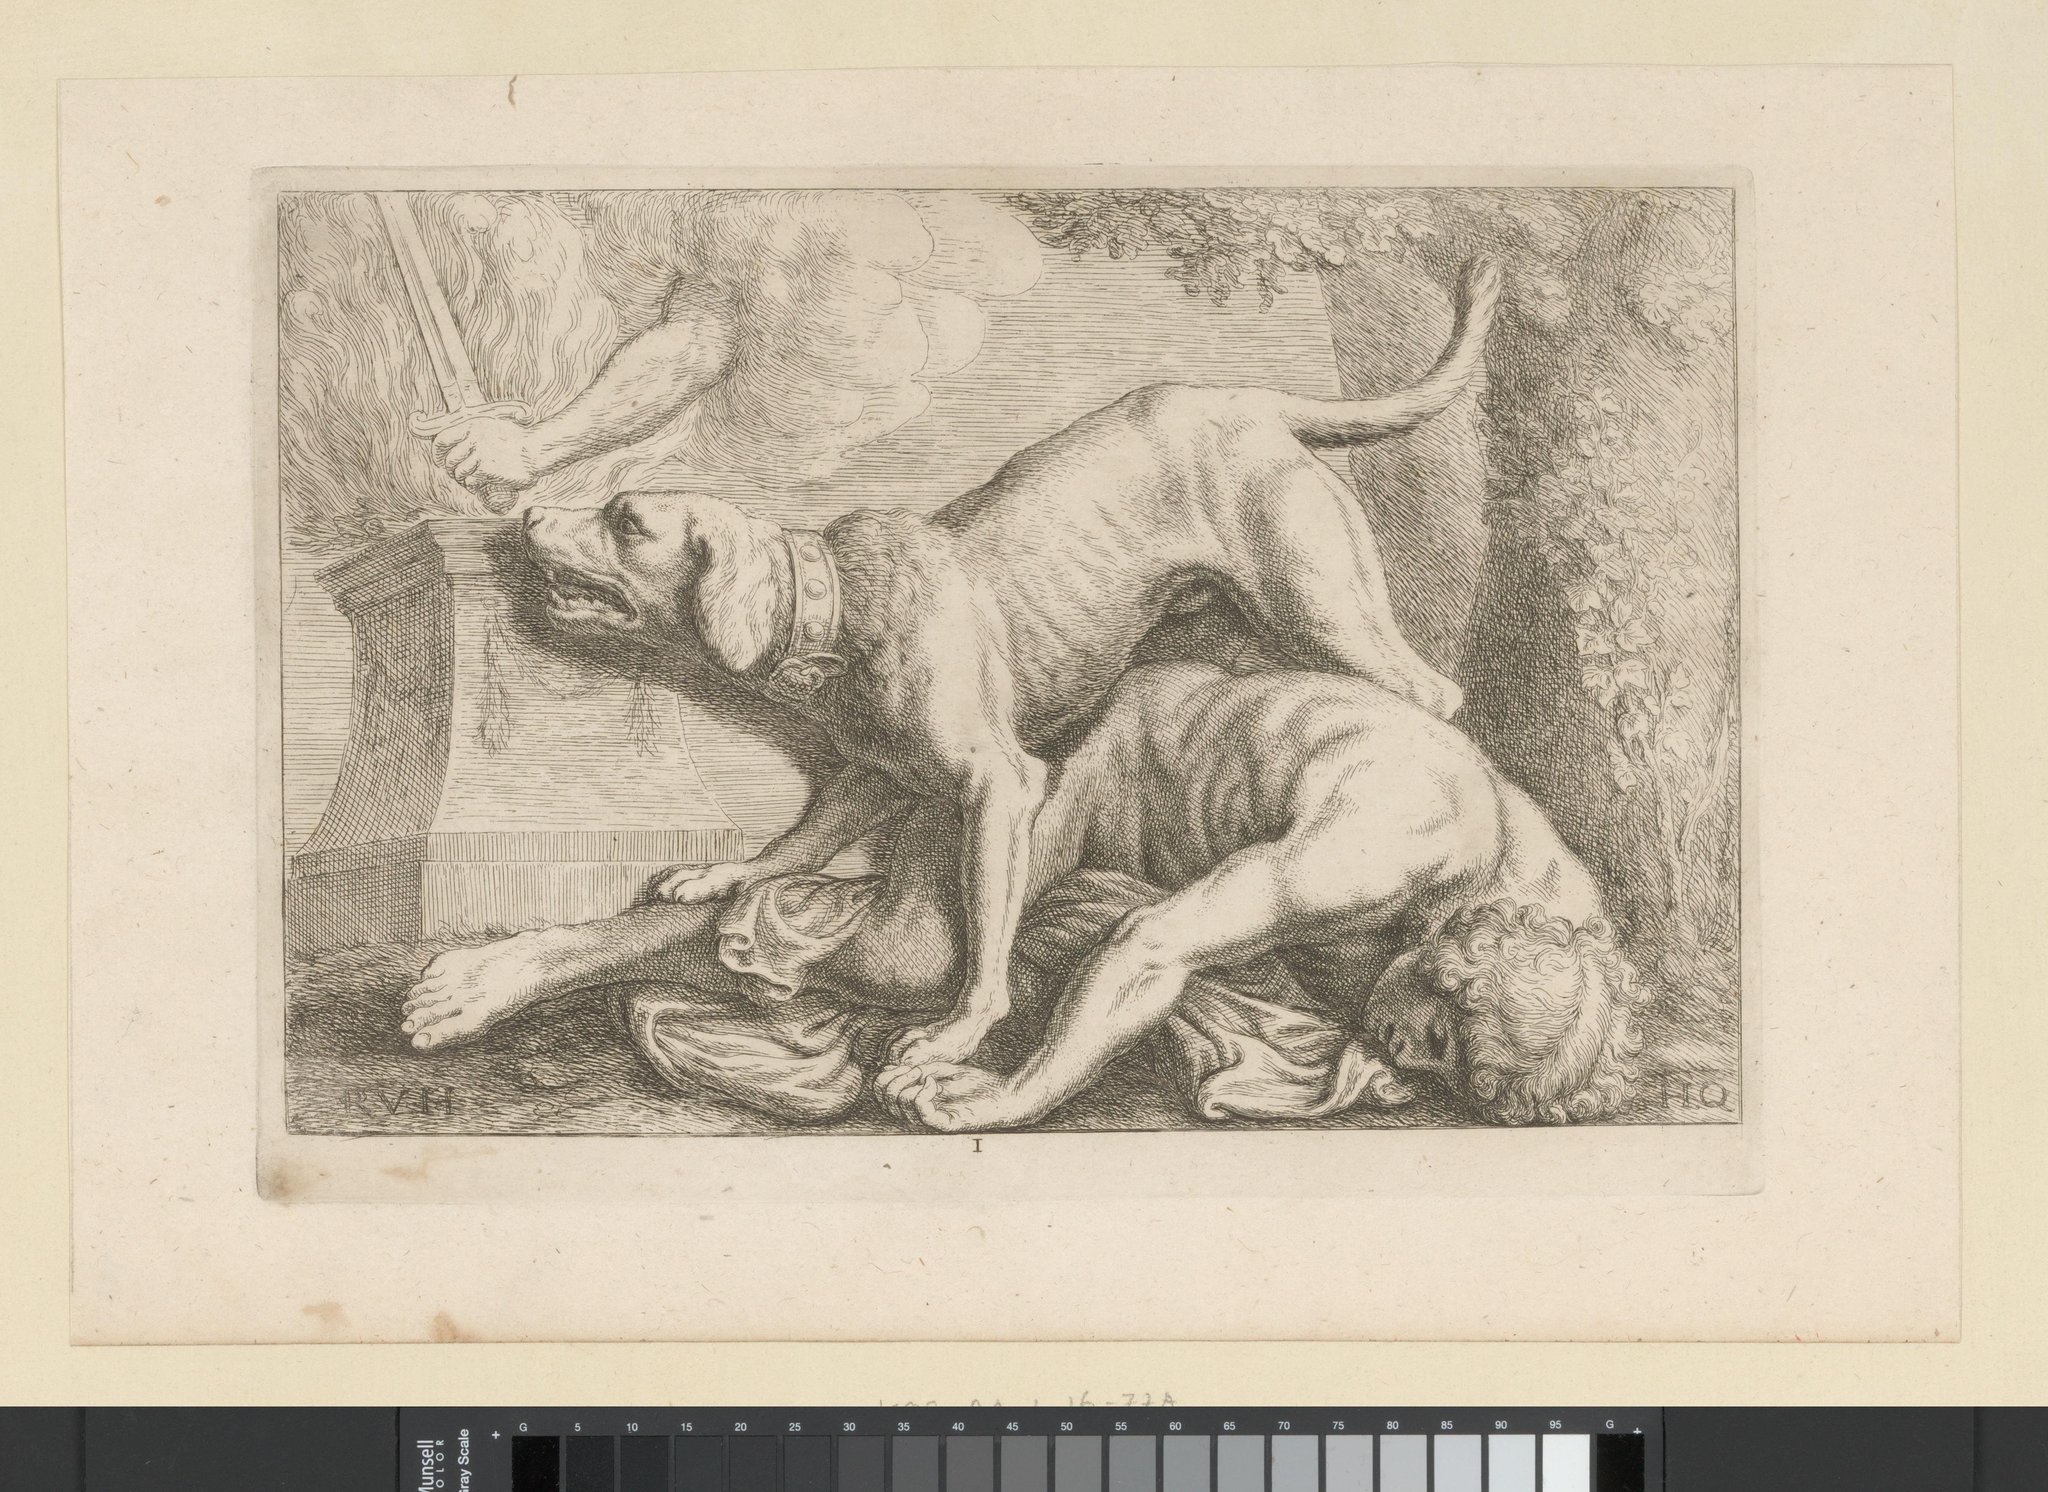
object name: print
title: Reliëf met hond als allegorie op de Trouw boven de linker deur naar het Secretarie in het Stadhuis op de Dam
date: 1663-1668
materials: paper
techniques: engraving, etching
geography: amsterdam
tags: faithfulness, 'bona fide', fidelity; 'fedeltà' (ripa), roman personifications of abstract concepts, townhall, frankness, loyalty; 'lealtà', 'realtà' (ripa), dog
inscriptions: collector's mark: ‘16,77’ Lugt 1641b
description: Huidige staat van prent ook gebruikt in: Secunca pars Praecipuarum effigierum ac ornamentorum amplissime Curiae Amstelrodamensis maiori ex parte in cadido marmore effectorum per Artum Quellinium eiusdem Civitatis Statuarium / Het tweede deel Van de voornaemste Statuen ende Cieraten van 't konst-rijcke Stadt-huys van Amstelredam 'tmeeste in Marmer gemaeckt door Artus Quellinus Beelthouwer der voorseyde Stadt. Amsterdam: Artus Quellinus (I), 1663. En in: Secunca pars Praecipuarum effigierum ac ornamentorum amplissime Curiae Amstelrodamensis maiori ex parte in cadido marmore effectorum per Artum Quellinium eiusdem Civitatis Statuarium / Het tweede deel Van de voornaemste Statuen ende Cieraten van 't konst-rijcke Stadt-huys van Amstelredam 'tmeeste in Marmer gemaeckt door Artus Quellinus Beelthouwer der voorseyde Stadt. Amsterdam: Frederik de Wit, 1668. Latere staat van prent ook gebruikt in: Architecture peinture et sculpture de la Maison de Ville d'Amsterdam, representee en CIX. figures en taille-douce (…). Amsterdam: David Mortier, 1719. En in: Architecture peinture et sculpture de la Maison de Ville d'Amsterdam, representee en CIX. figures en taille-douce (…). Amsterdam: Gerard Valck, 1719. En in: Bouw schilder en beeldhouwkonst, van het Stadhuis te Amsteldam, vertoont in CIX figuuren (…). Amsterdam: Covens & Mortier & Covens Jr., s.a. (1774-1783).